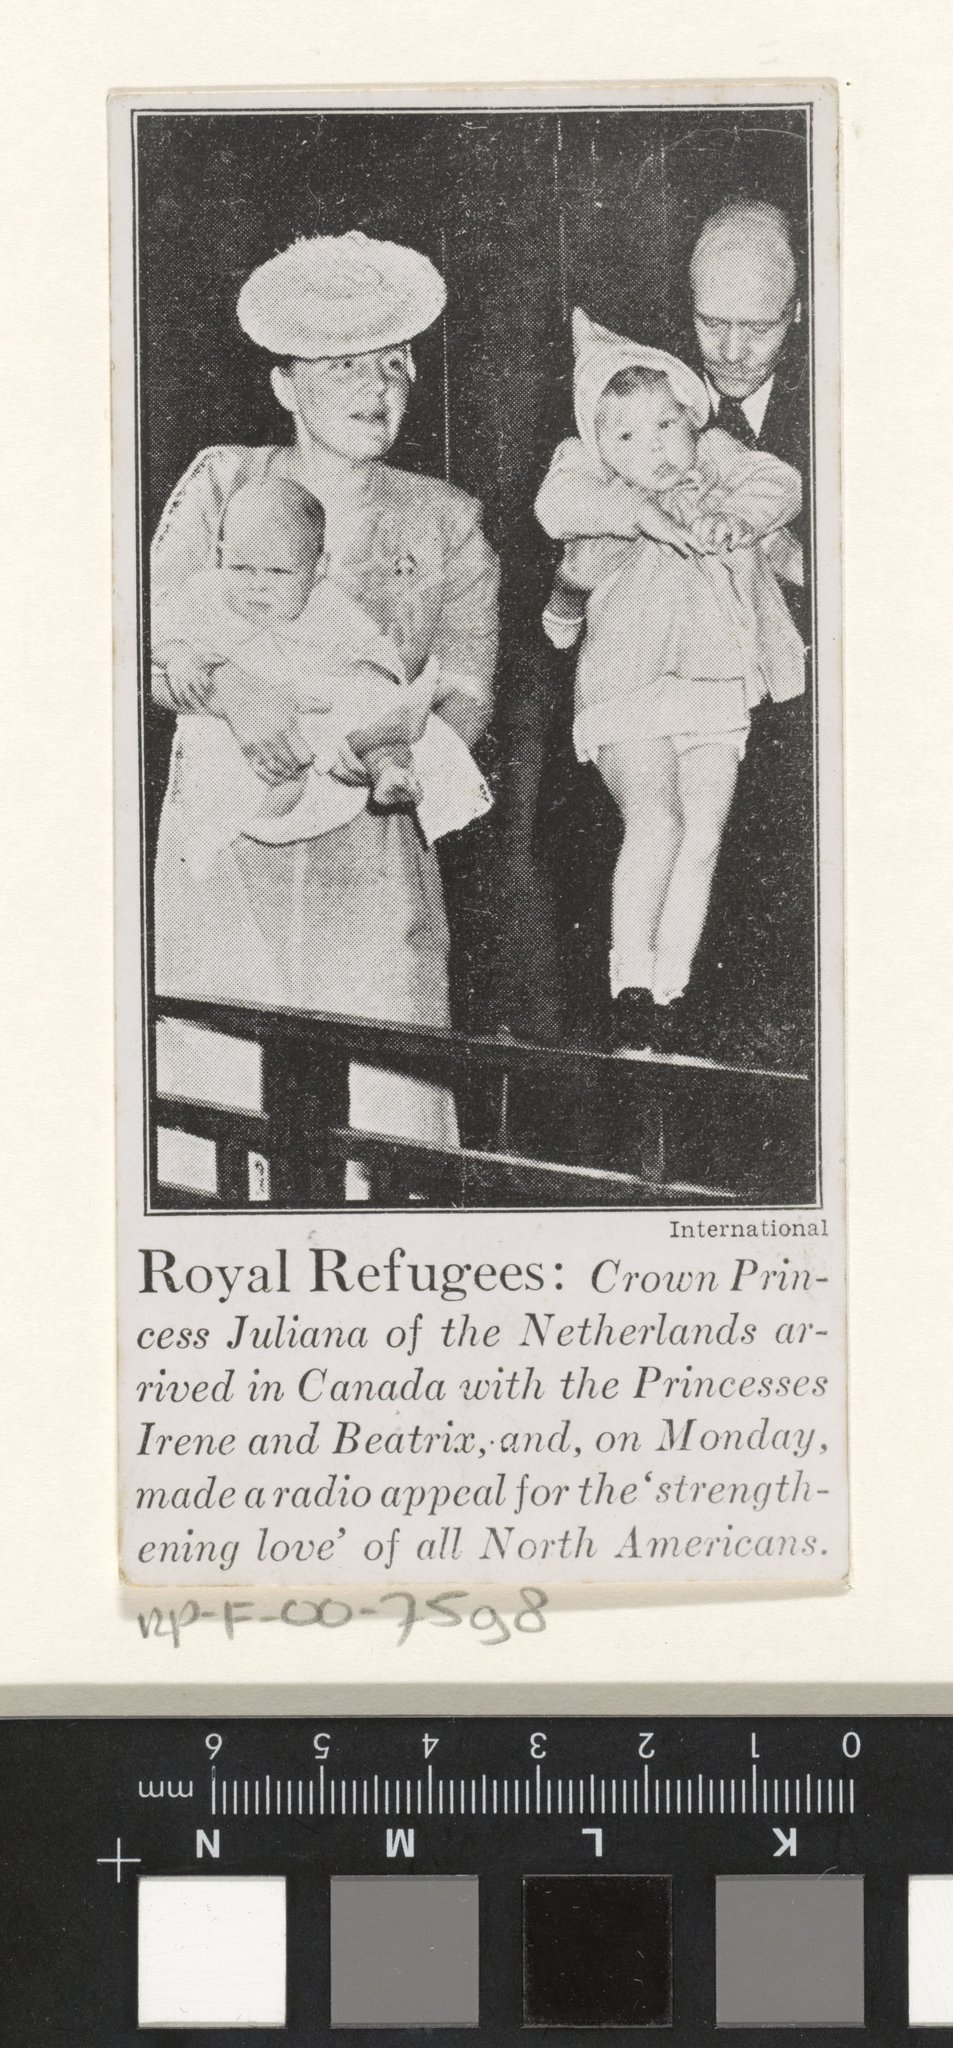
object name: ansichtkaart, prentbriefkaart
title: Portret van Juliana, koningin der Nederlanden, Bernhard van Lippe-Biesterfeld, Beatrix, koningin der Nederlanden, en Irene, prinses der Nederlanden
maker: Anonymous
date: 1940-1942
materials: photographic support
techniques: photography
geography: netherlands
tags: utrecht, bernhard (prins der nederlanden), beatrix (koningin der nederlanden), the hague, juliana of the netherlands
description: De hier vermelde titel verwijst naar de hoogst verkregen titel van de geportretteerde, niet per se naar de titel die de geportretteerde op deze voorstelling draagt. Foto naar een autotypie naar een foto.